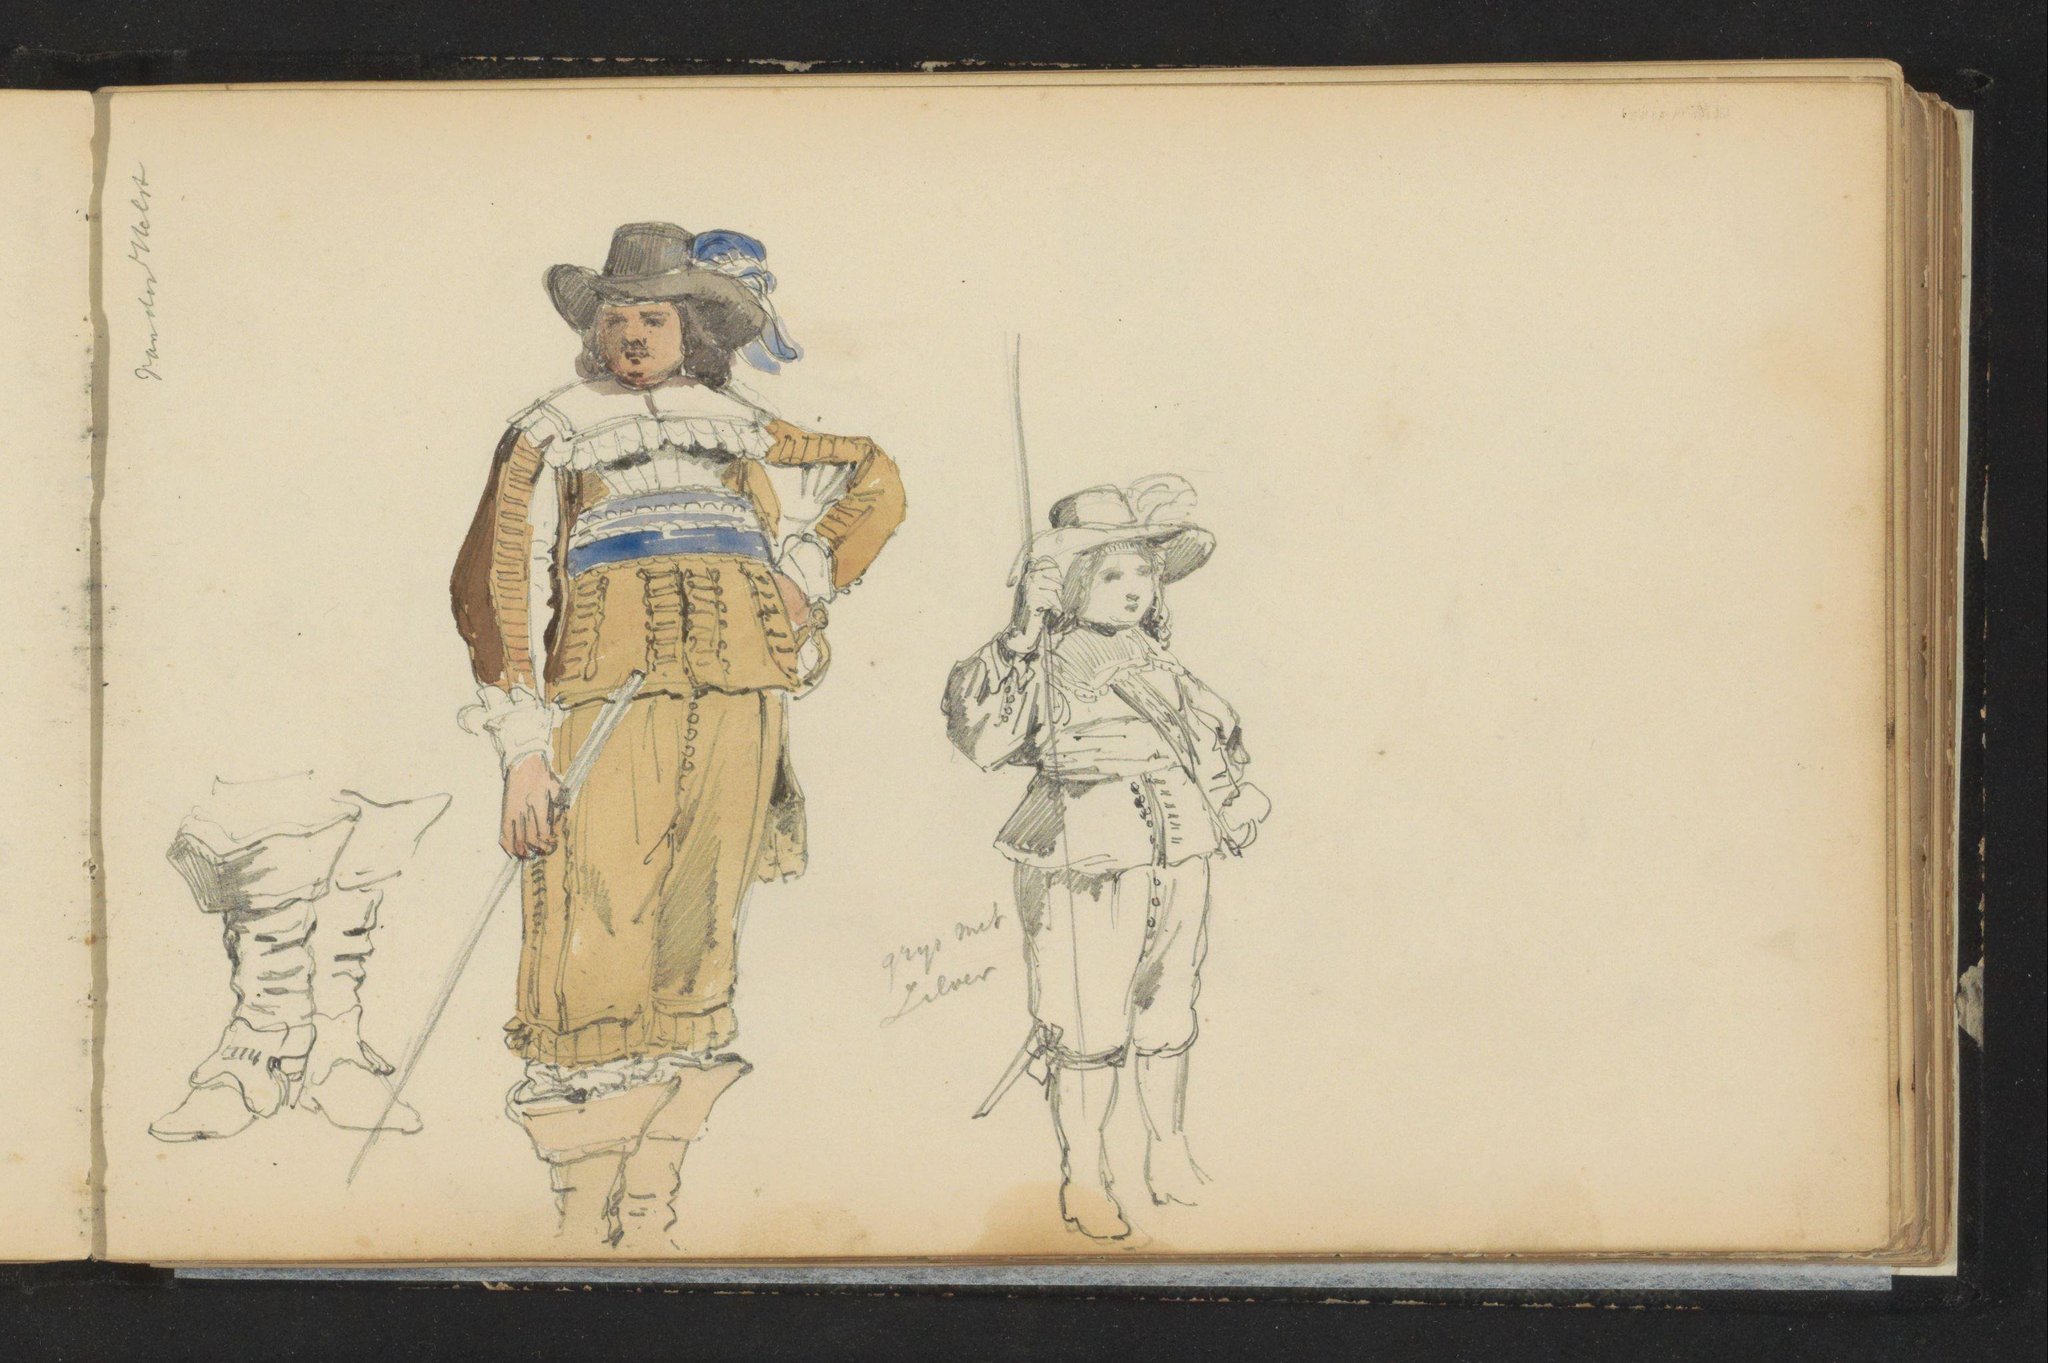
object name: sketchbook leaf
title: Roelof Bicker en een jongen in zeventiende-eeuwse kleding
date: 1846-1882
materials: paper, pencil, watercolor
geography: amsterdam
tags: amsterdam, clothes, costume (+ children's clothes), boy (child between toddler and youth), adult man, clothes, costume (+ men's clothes)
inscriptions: annotation: ‘Van der Helst’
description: Naar figuren op 'Officieren en andere schutters van wijk VIII in Amsterdam onder leiding van kapitein Roelof Bicker en luitenant Jan Michielsz Blaeuw' van Bartholomeus van der Helst, 1639 (Rijksmuseum Amsterdam).